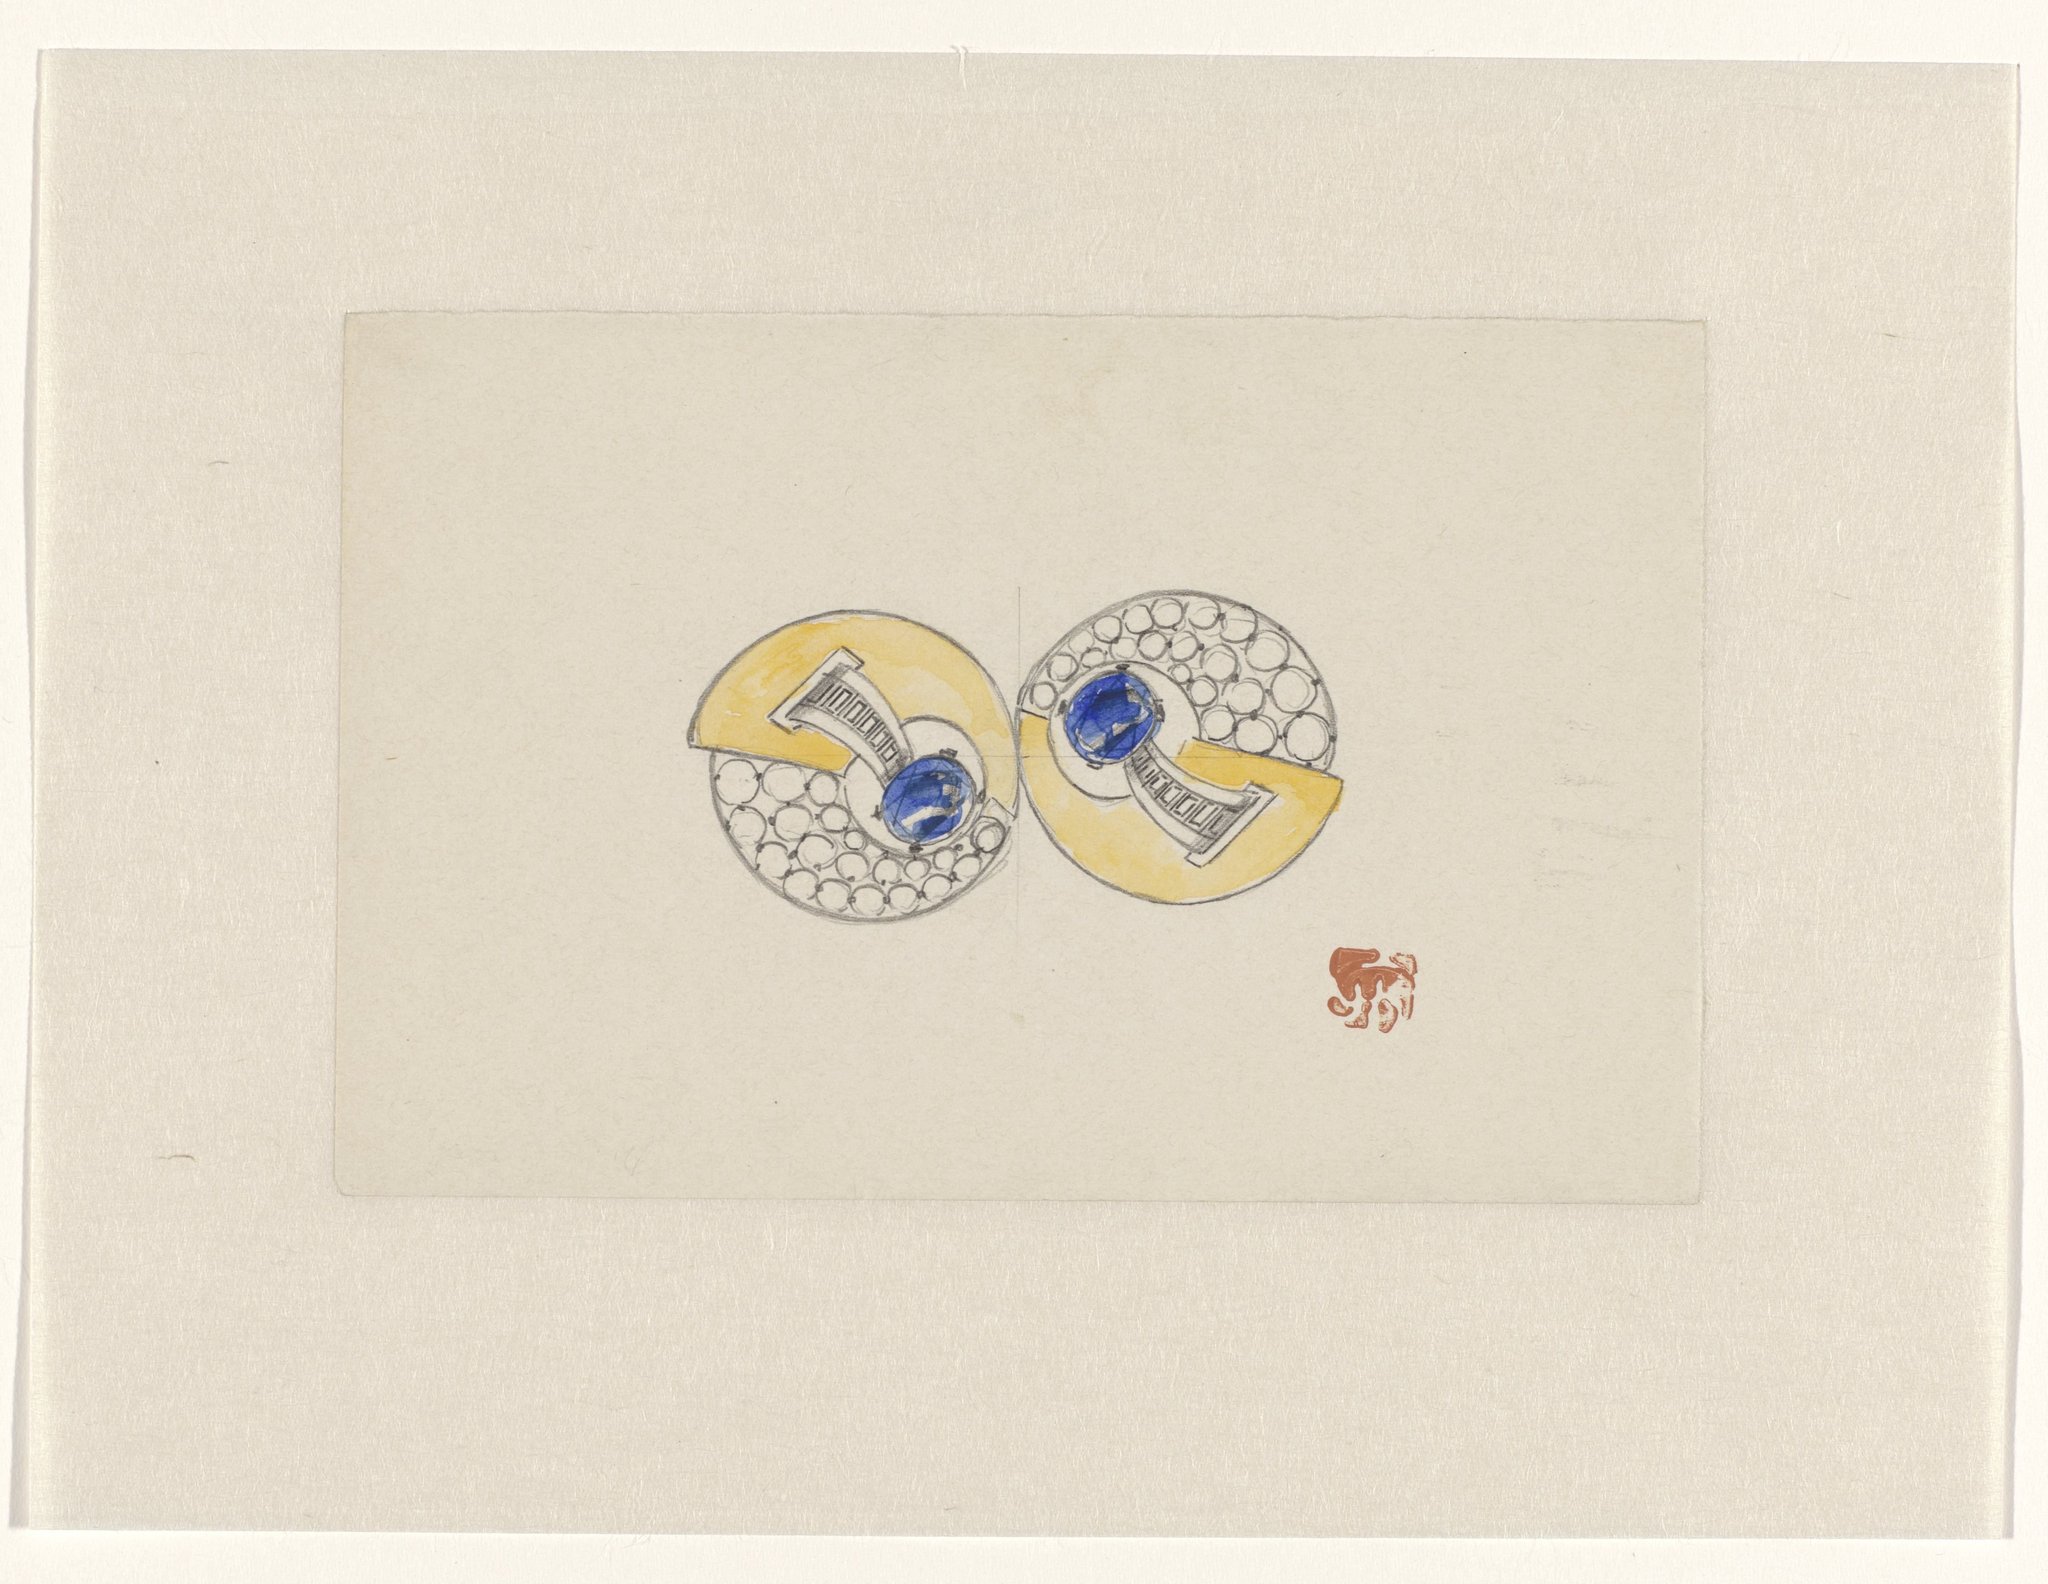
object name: drawing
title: Ontwerp voor juweel, opgebouwd uit twee ronde helften, met goud, saffieren en briljanten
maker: jules chadel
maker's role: draughtsman, print maker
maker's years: 1870-1941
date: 1920-1930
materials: paper, pencil, watercolor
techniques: brush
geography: paris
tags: ornaments, jewels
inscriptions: stamp: Lugt 562 b